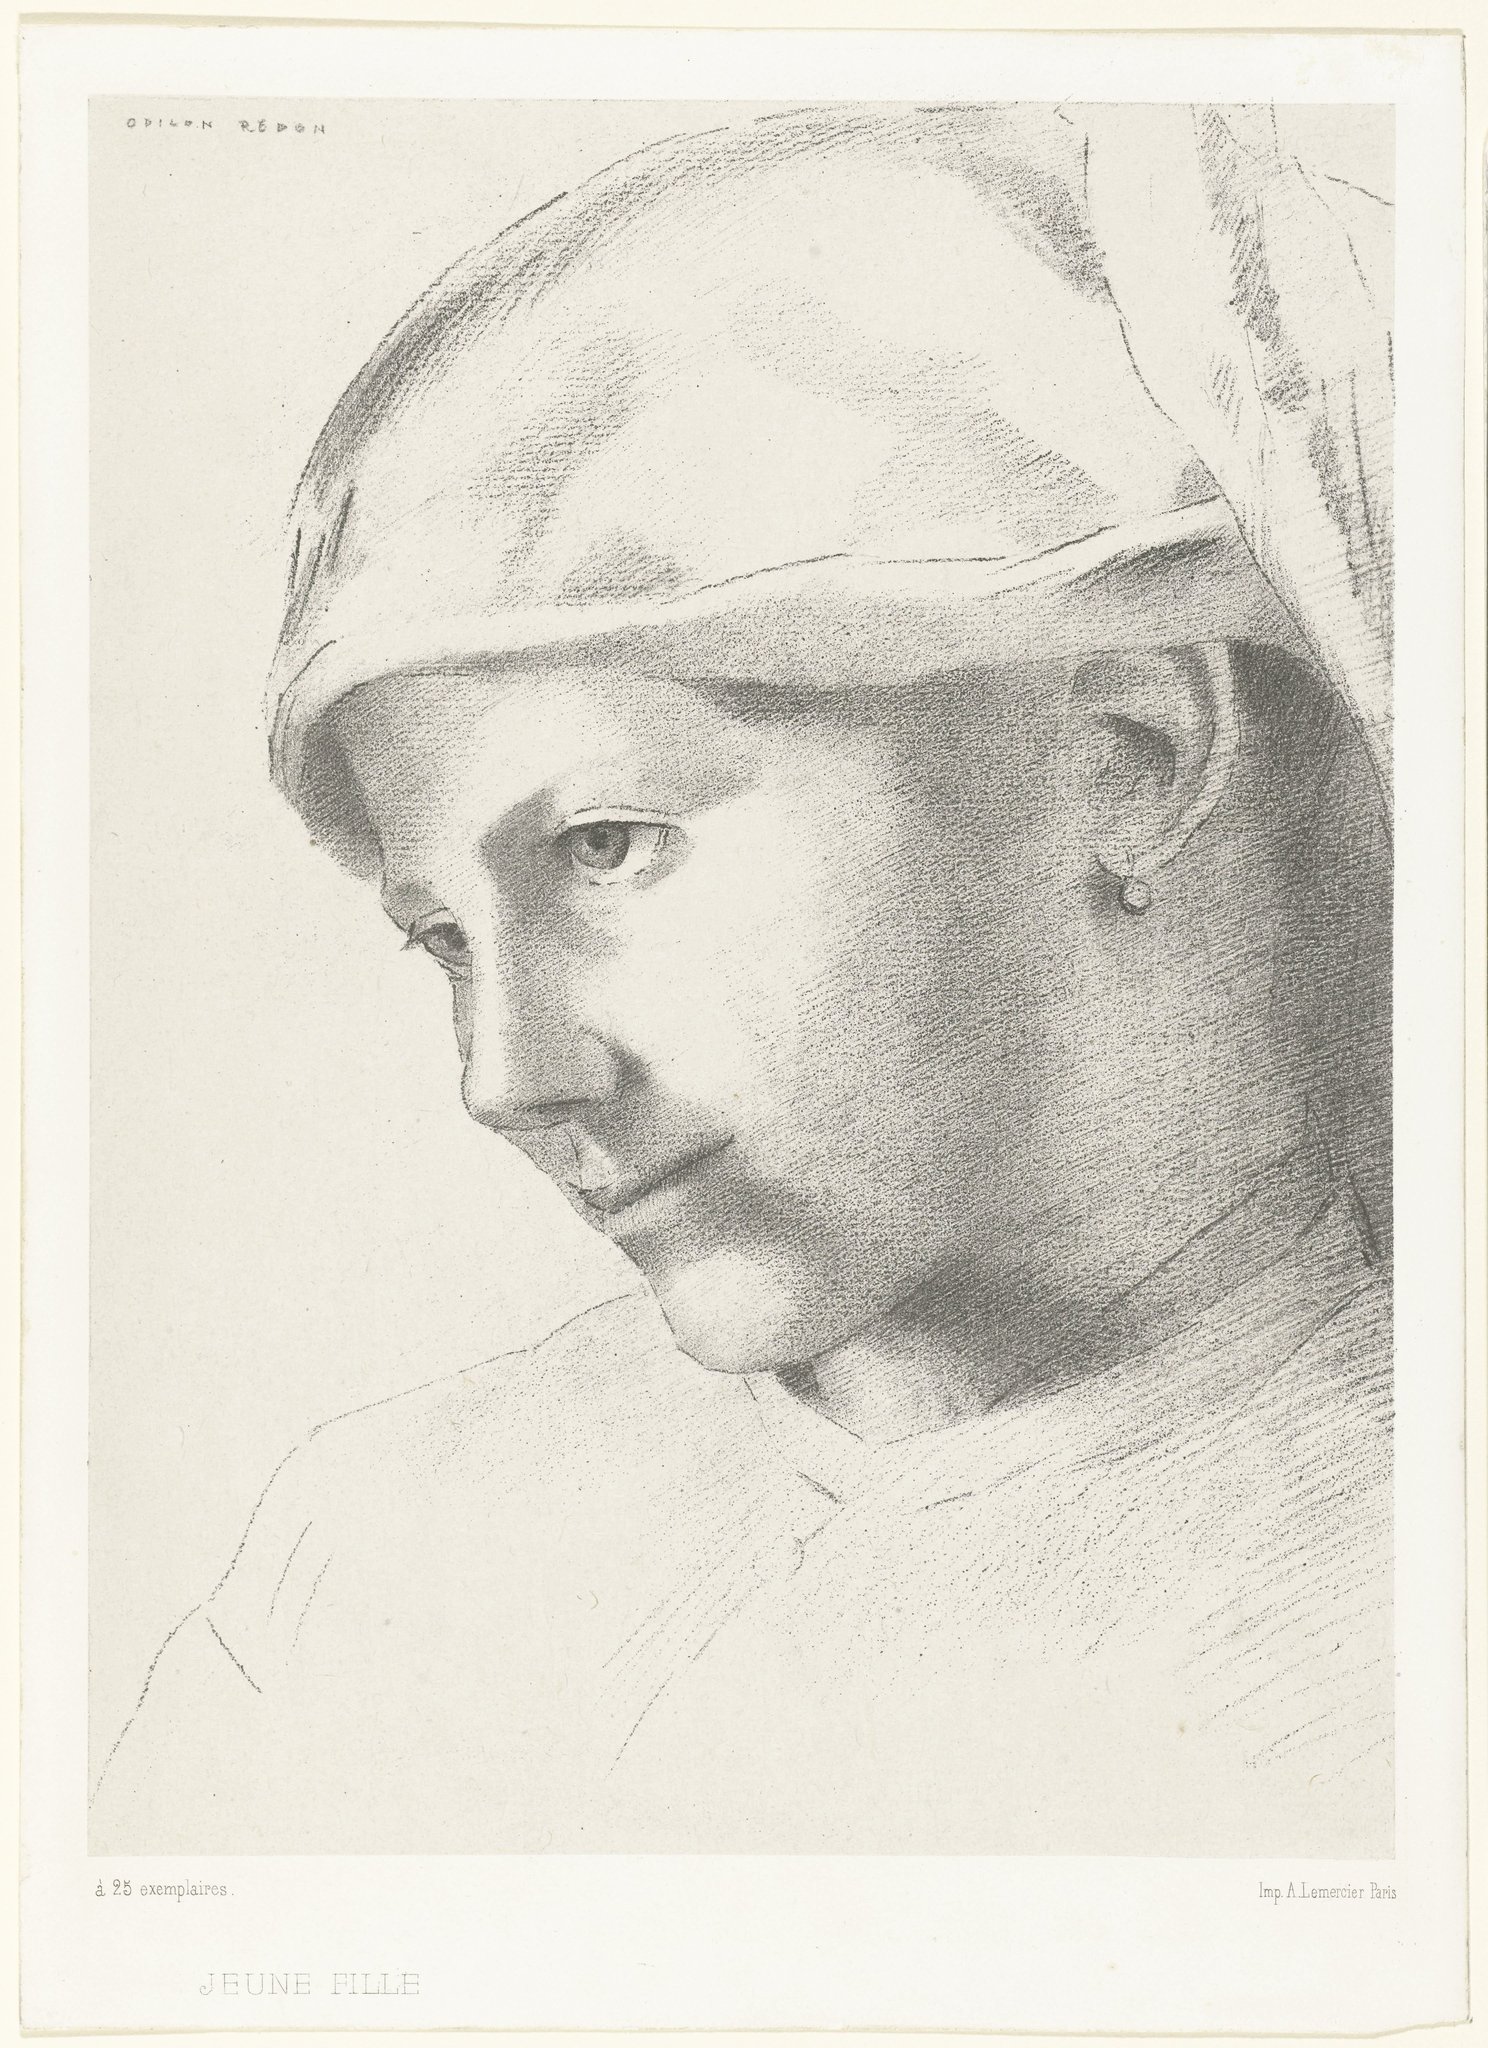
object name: print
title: Jeune Fille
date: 1887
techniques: printmaking, lithograph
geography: paris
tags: adolescent, young woman, maiden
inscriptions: collector's mark: Lugt 2228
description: Buste van een jong meisje met een hoofddoek om.